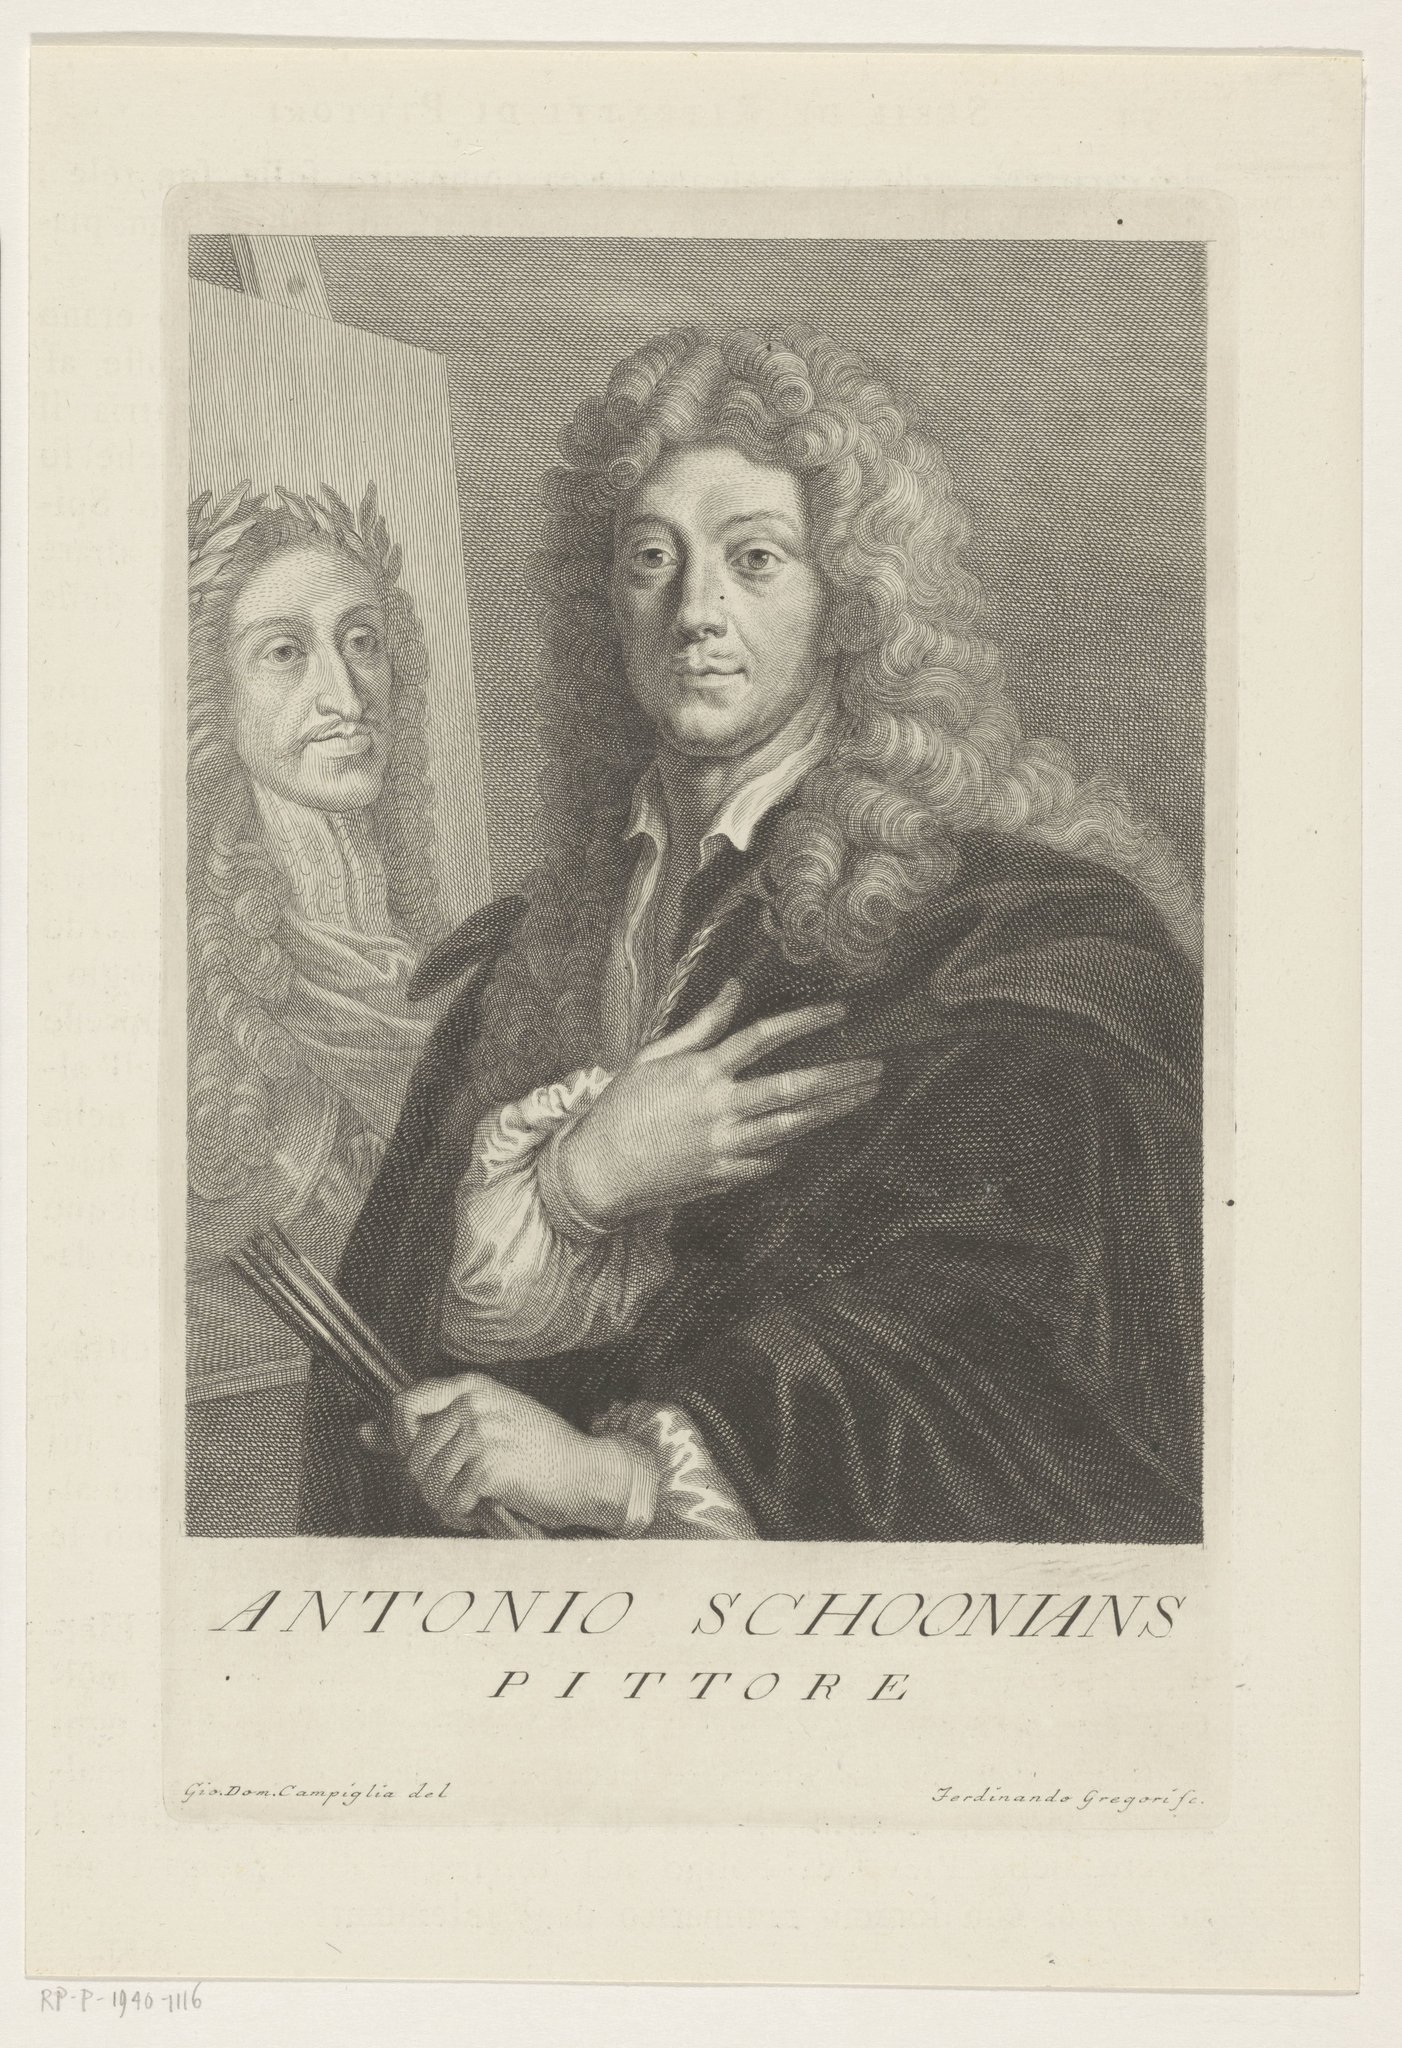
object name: print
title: Portretten van kunstenaars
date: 1752-1762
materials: paper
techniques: engraving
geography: italy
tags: antwerp, painter, anthon schoonjans, historical persons, portrait, self-portrait of artist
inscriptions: collector's mark: Lugt 2760, collector's mark: ‘RIJKS / MUSM’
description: Prent uit: Moücke, Francesco. Serie di ritratti degli eccellenti pittori dipinti di propria mano, che esistono nell'Imiperial Galleria di Firenze. Florence: 1752-1762.